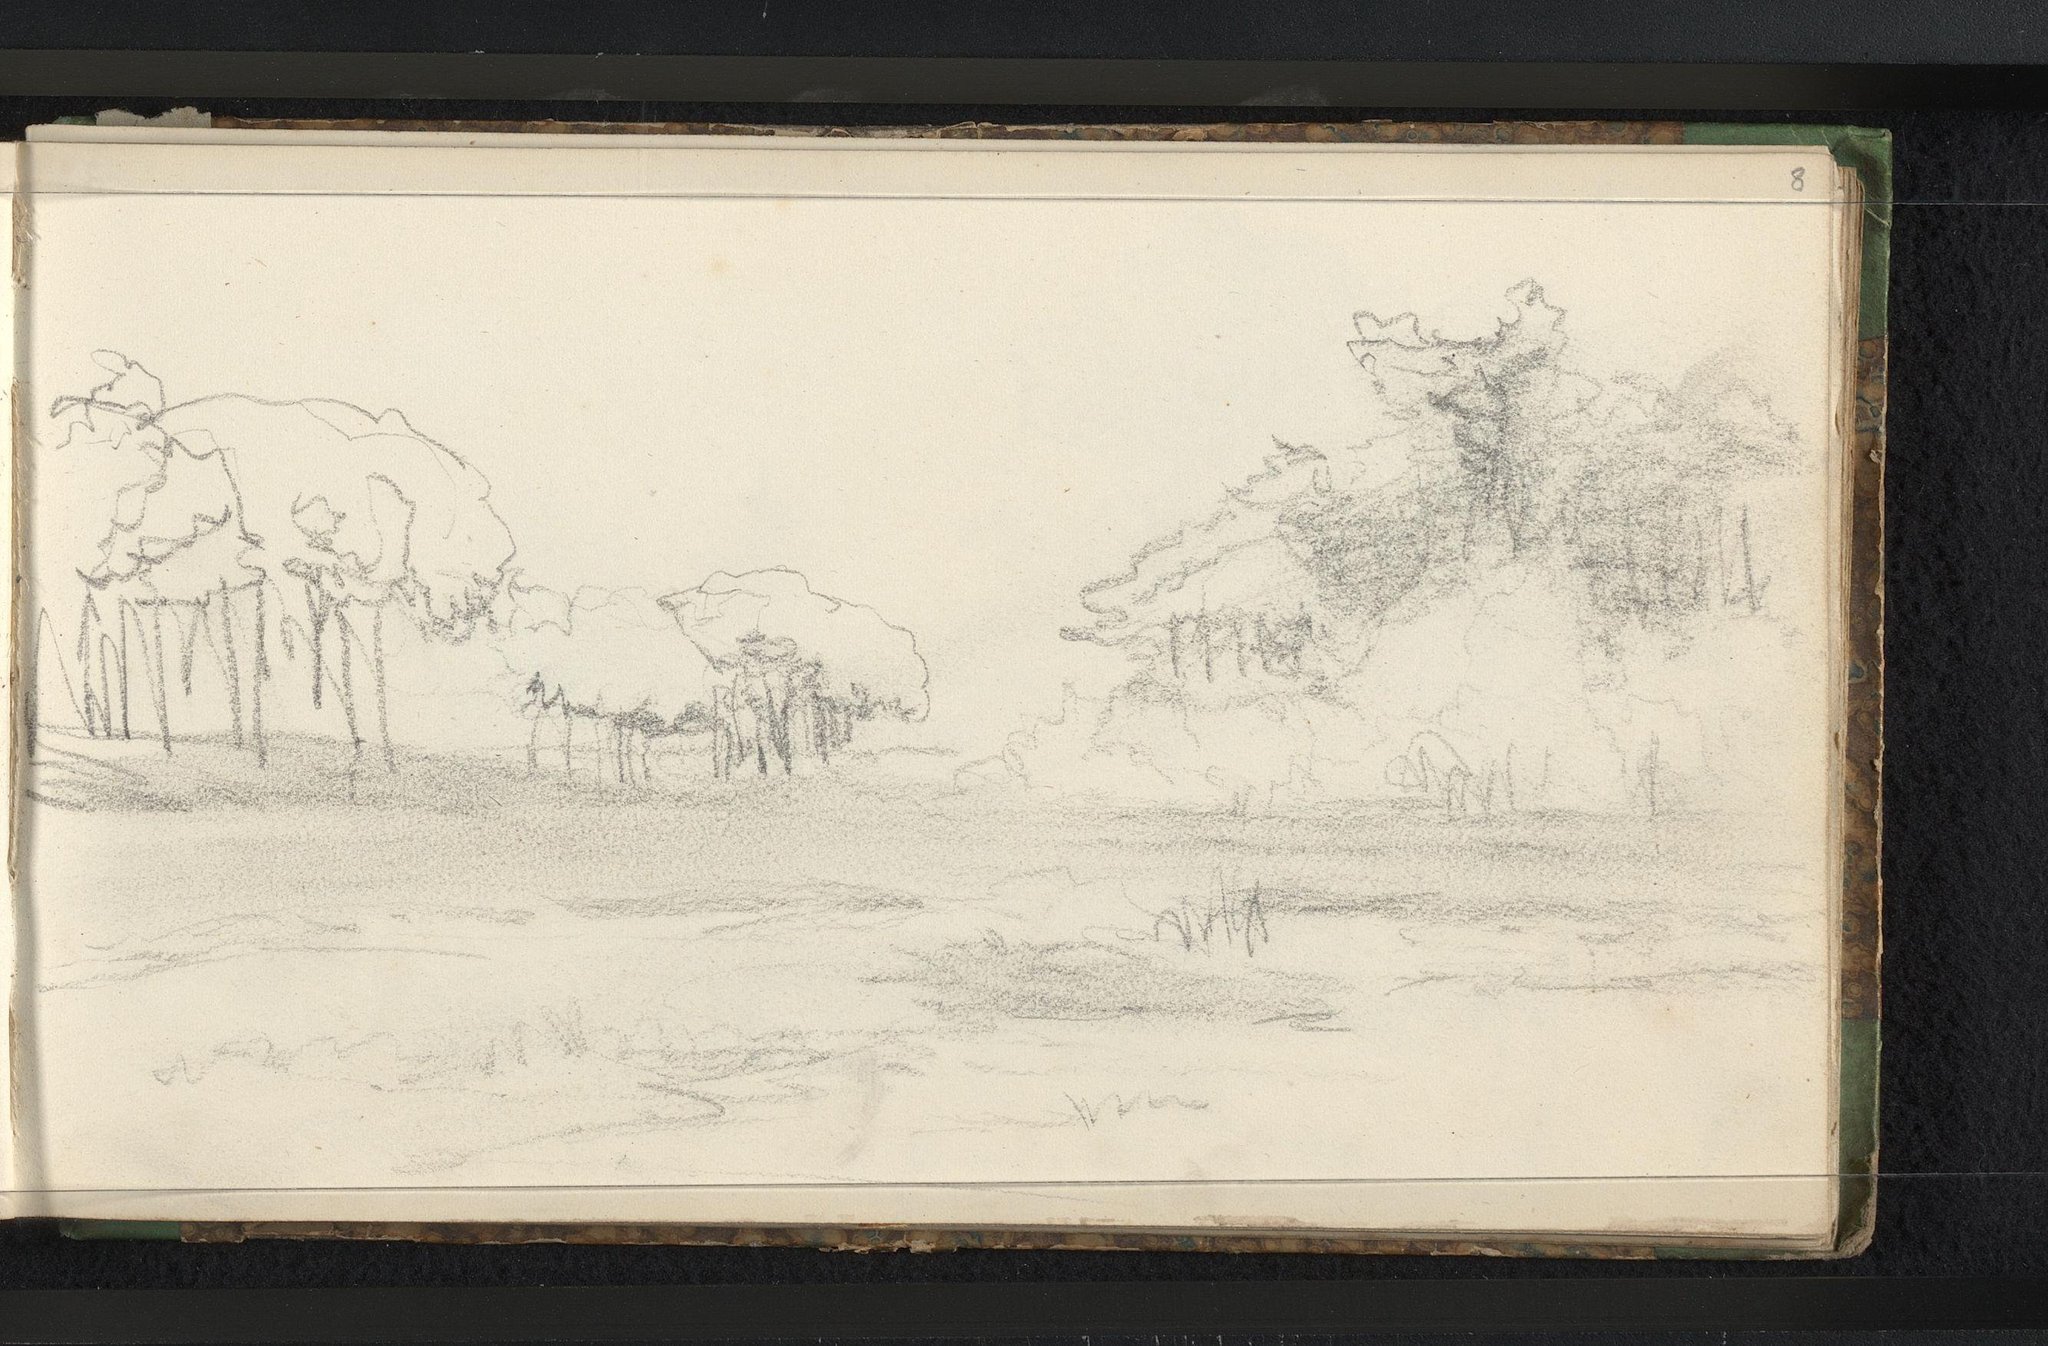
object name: sketchbook leaf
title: Landschap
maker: jan bedijs tom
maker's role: draughtsman, painter, print maker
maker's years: 1813-1894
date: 1828-1894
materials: paper, pencil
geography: the hague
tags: trees, landscapes, artist (in general) making preliminary designs, sketching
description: Pagina 8 recto uit een schetsboek met 50 bladen.